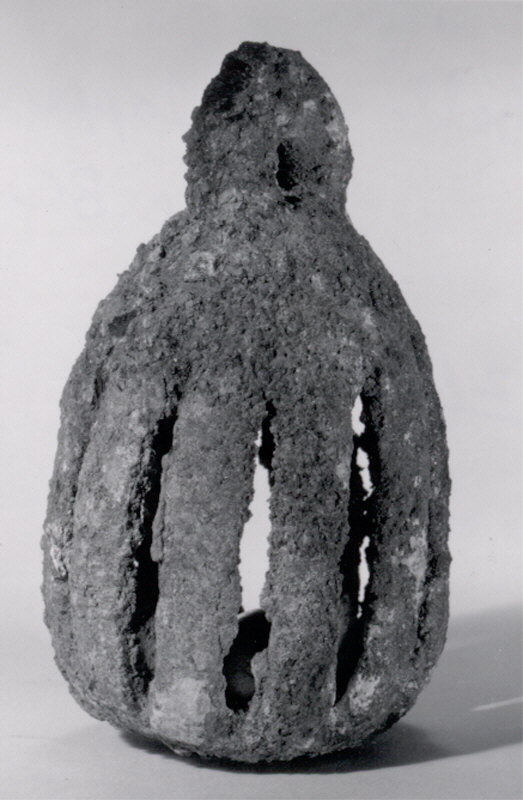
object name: bell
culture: iranian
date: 900-801 BCE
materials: bronze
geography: iran